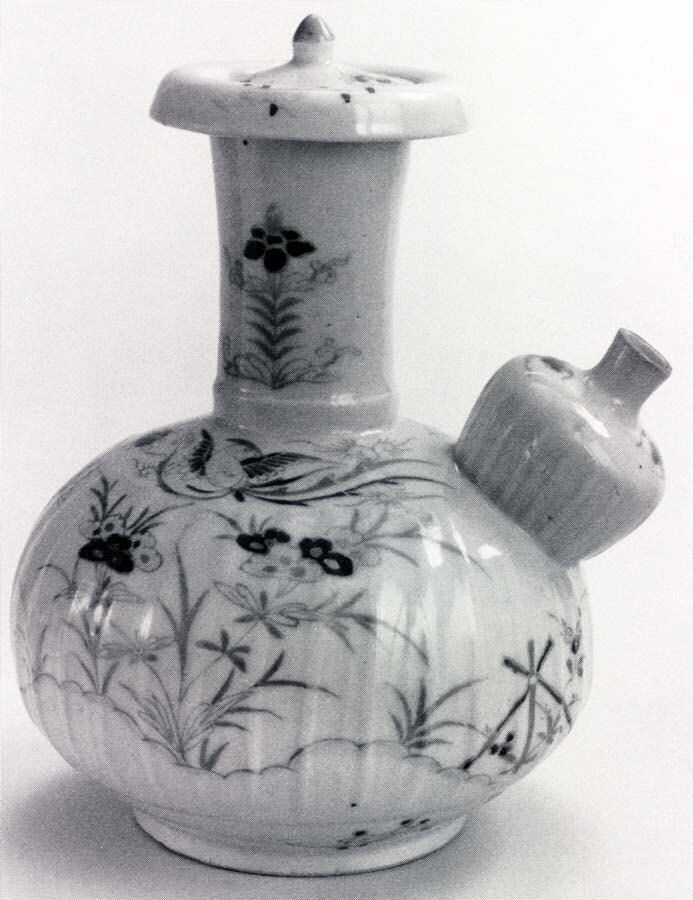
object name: bottle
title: Kundika (Long-Necked Bottle)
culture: japanese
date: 1701-1800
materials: enamel, gold, porcelain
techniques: overglaze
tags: flowers